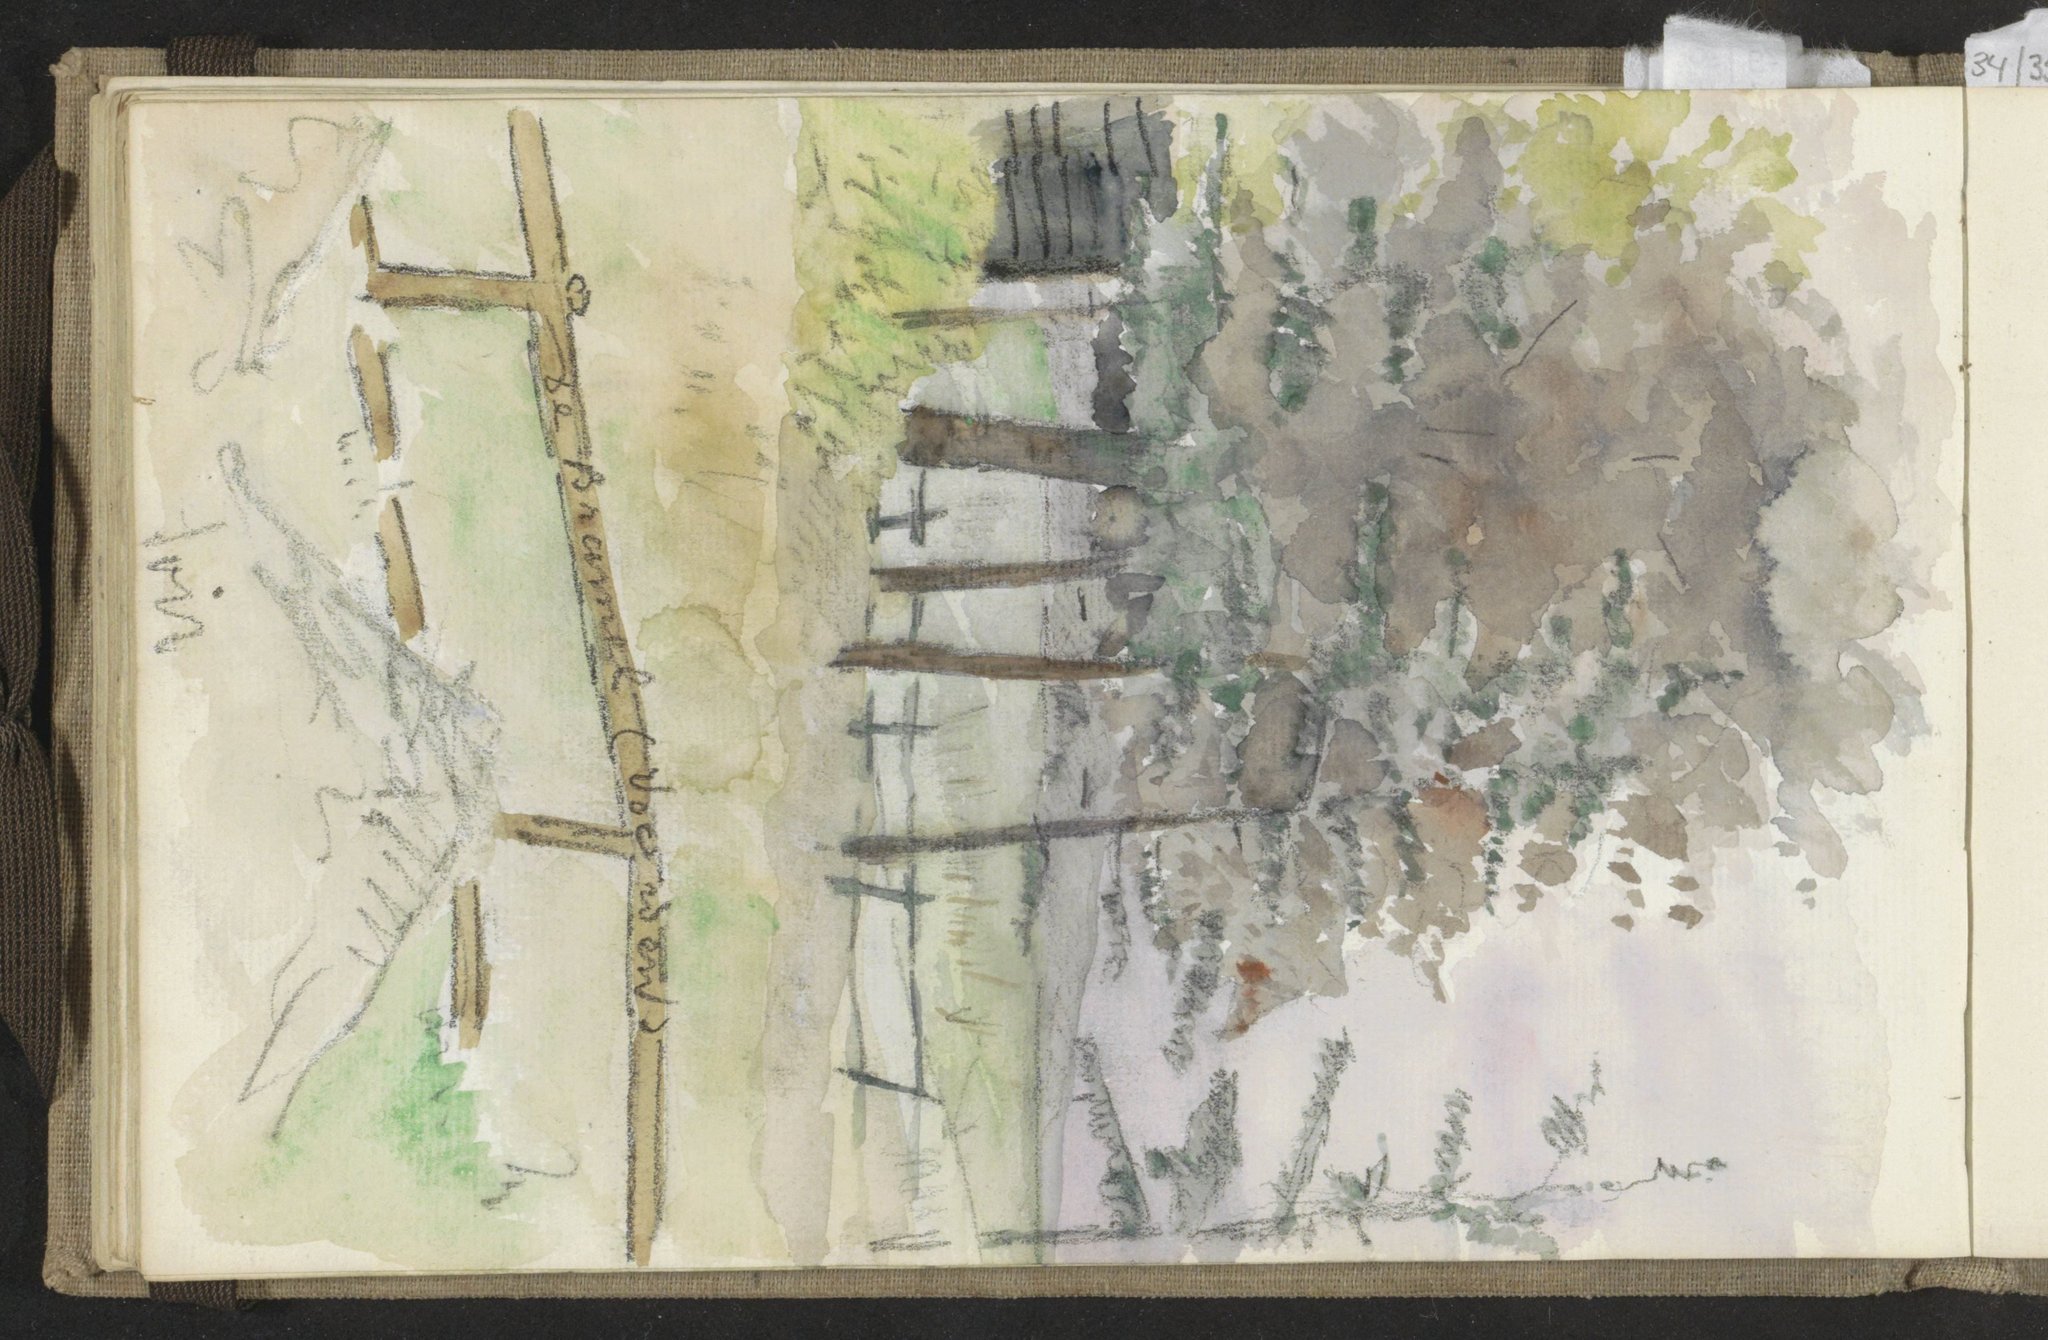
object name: sketchbook leaf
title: Landschap bij Kasteel Den Bramel te Vorden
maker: jonkheer johannes ludovicus paulus bosch van drakestein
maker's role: draughtsman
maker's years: 1865-1929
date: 1896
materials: paper, pencil, watercolor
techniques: brush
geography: vorden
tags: trees, fence, wall, paling, landscapes with waters, waterscapes, seascapes (in the temperate zone)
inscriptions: annotation: ‘De Bramel (Voorden)/ soir’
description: Blad 32 verso uit een schetsboek met 58 bladen.